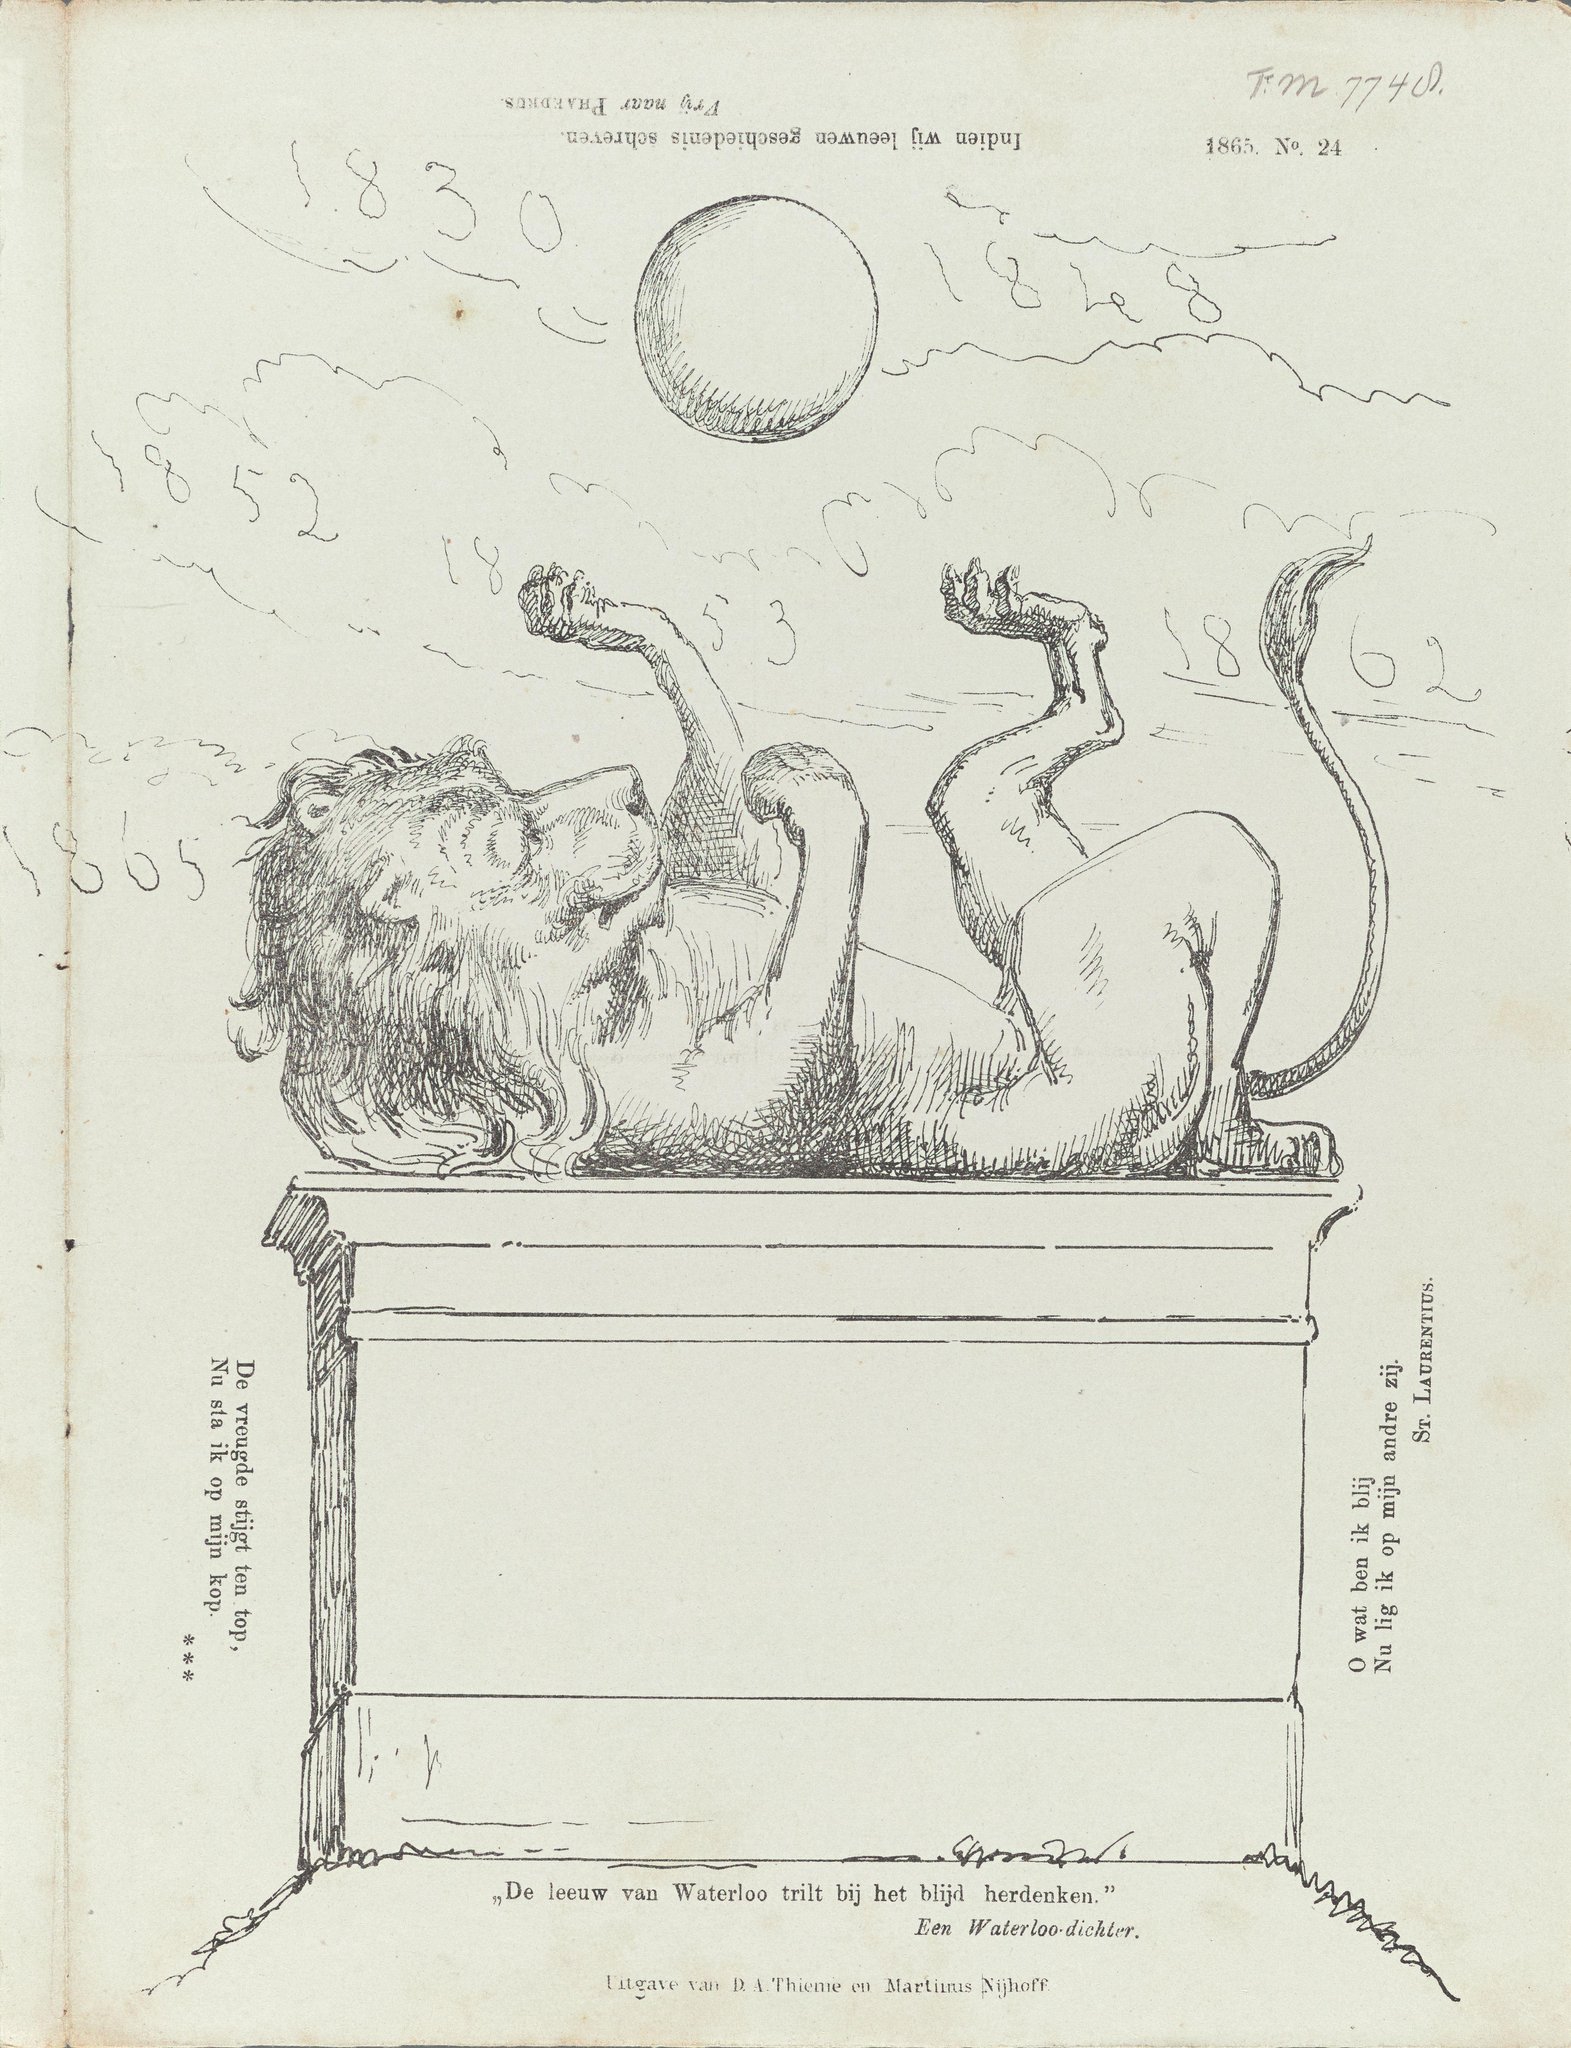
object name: cartoon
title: Spotprent over de Waterloo-feesten, 1865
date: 1865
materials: paper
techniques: lithograph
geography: netherlands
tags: beasts of prey, predatory animals: lion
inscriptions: collector's mark: Lugt 2228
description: Spotprent over de feesten ter gelegenheid van 50-jarig jubileum van de Slag bij Waterloo. De leeuw van het Waterloo-monument spellt liggend op zijn rug met de bal. Plaat verschenen bij het weekblad De Nederlandsche Spectator, nr. 24, 11 juni 1865.